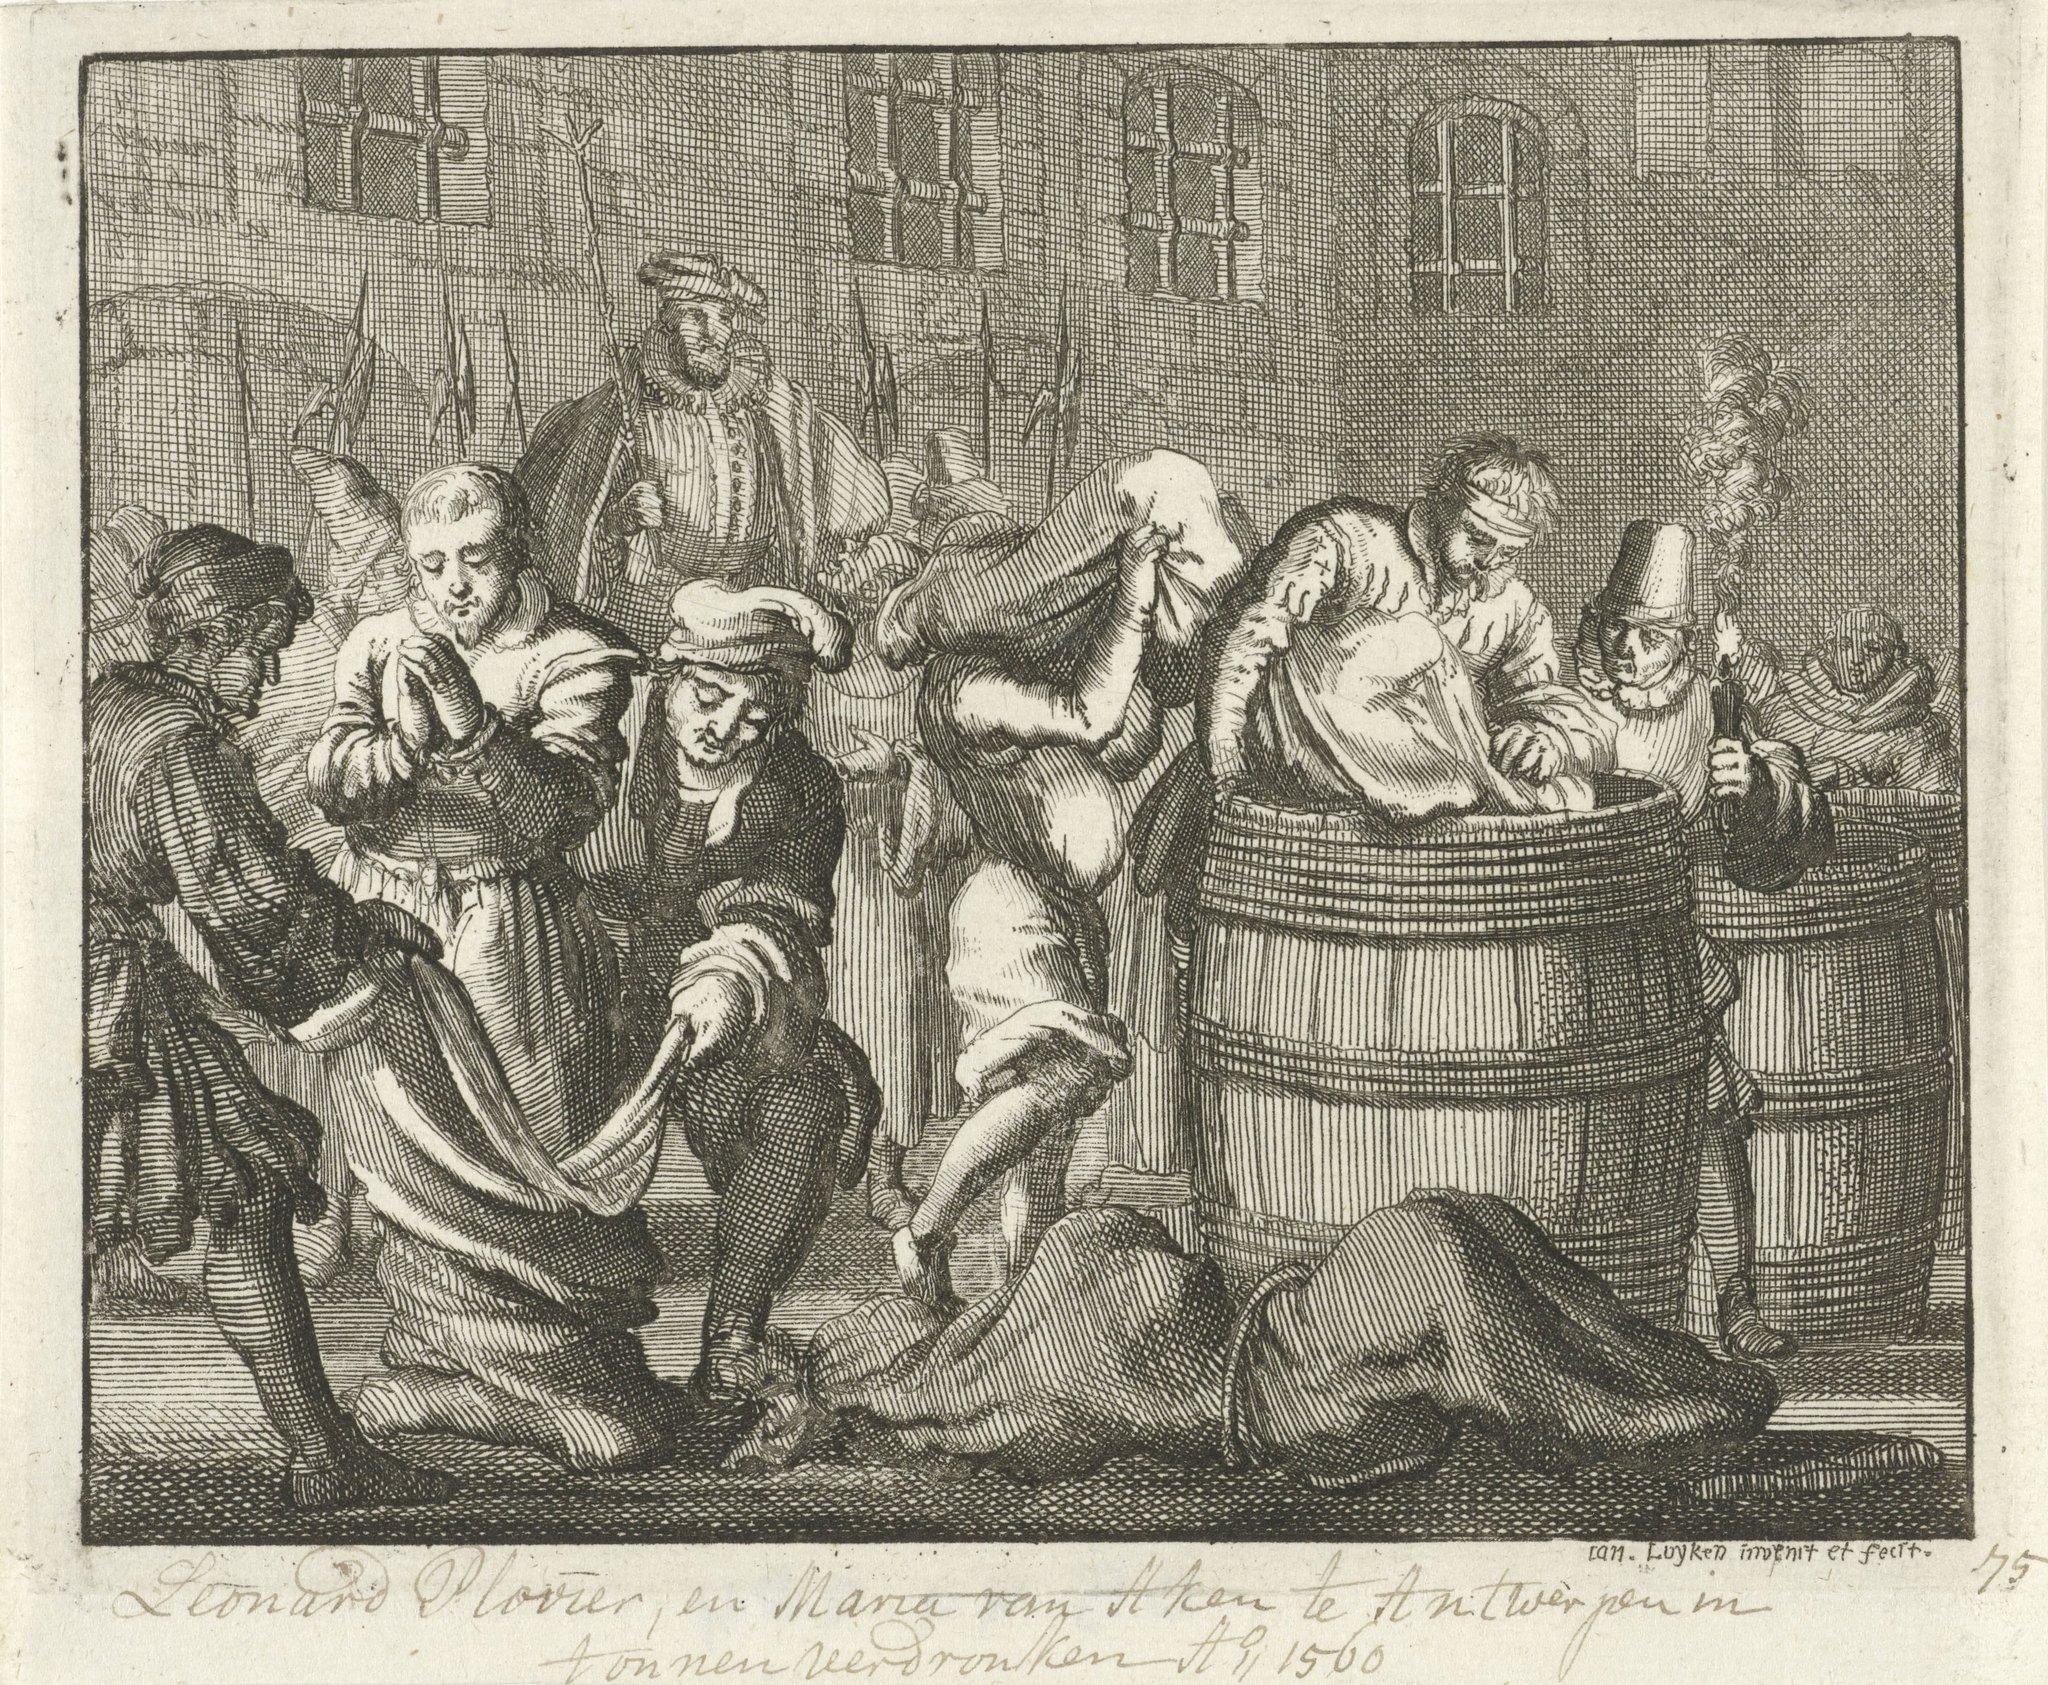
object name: print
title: Leonard Plovier en twee meisjes te Antwerpen in vaten verdronken, 1560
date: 1685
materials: paper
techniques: etching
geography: amsterdam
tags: antwerp, execution of heretic, e.g. by burning at the stake, 'auto-da-fé'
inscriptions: inscription: ‘Leonard Plovier [...] Ao 1560’, number: ‘75’, collector's mark: Lugt 2228